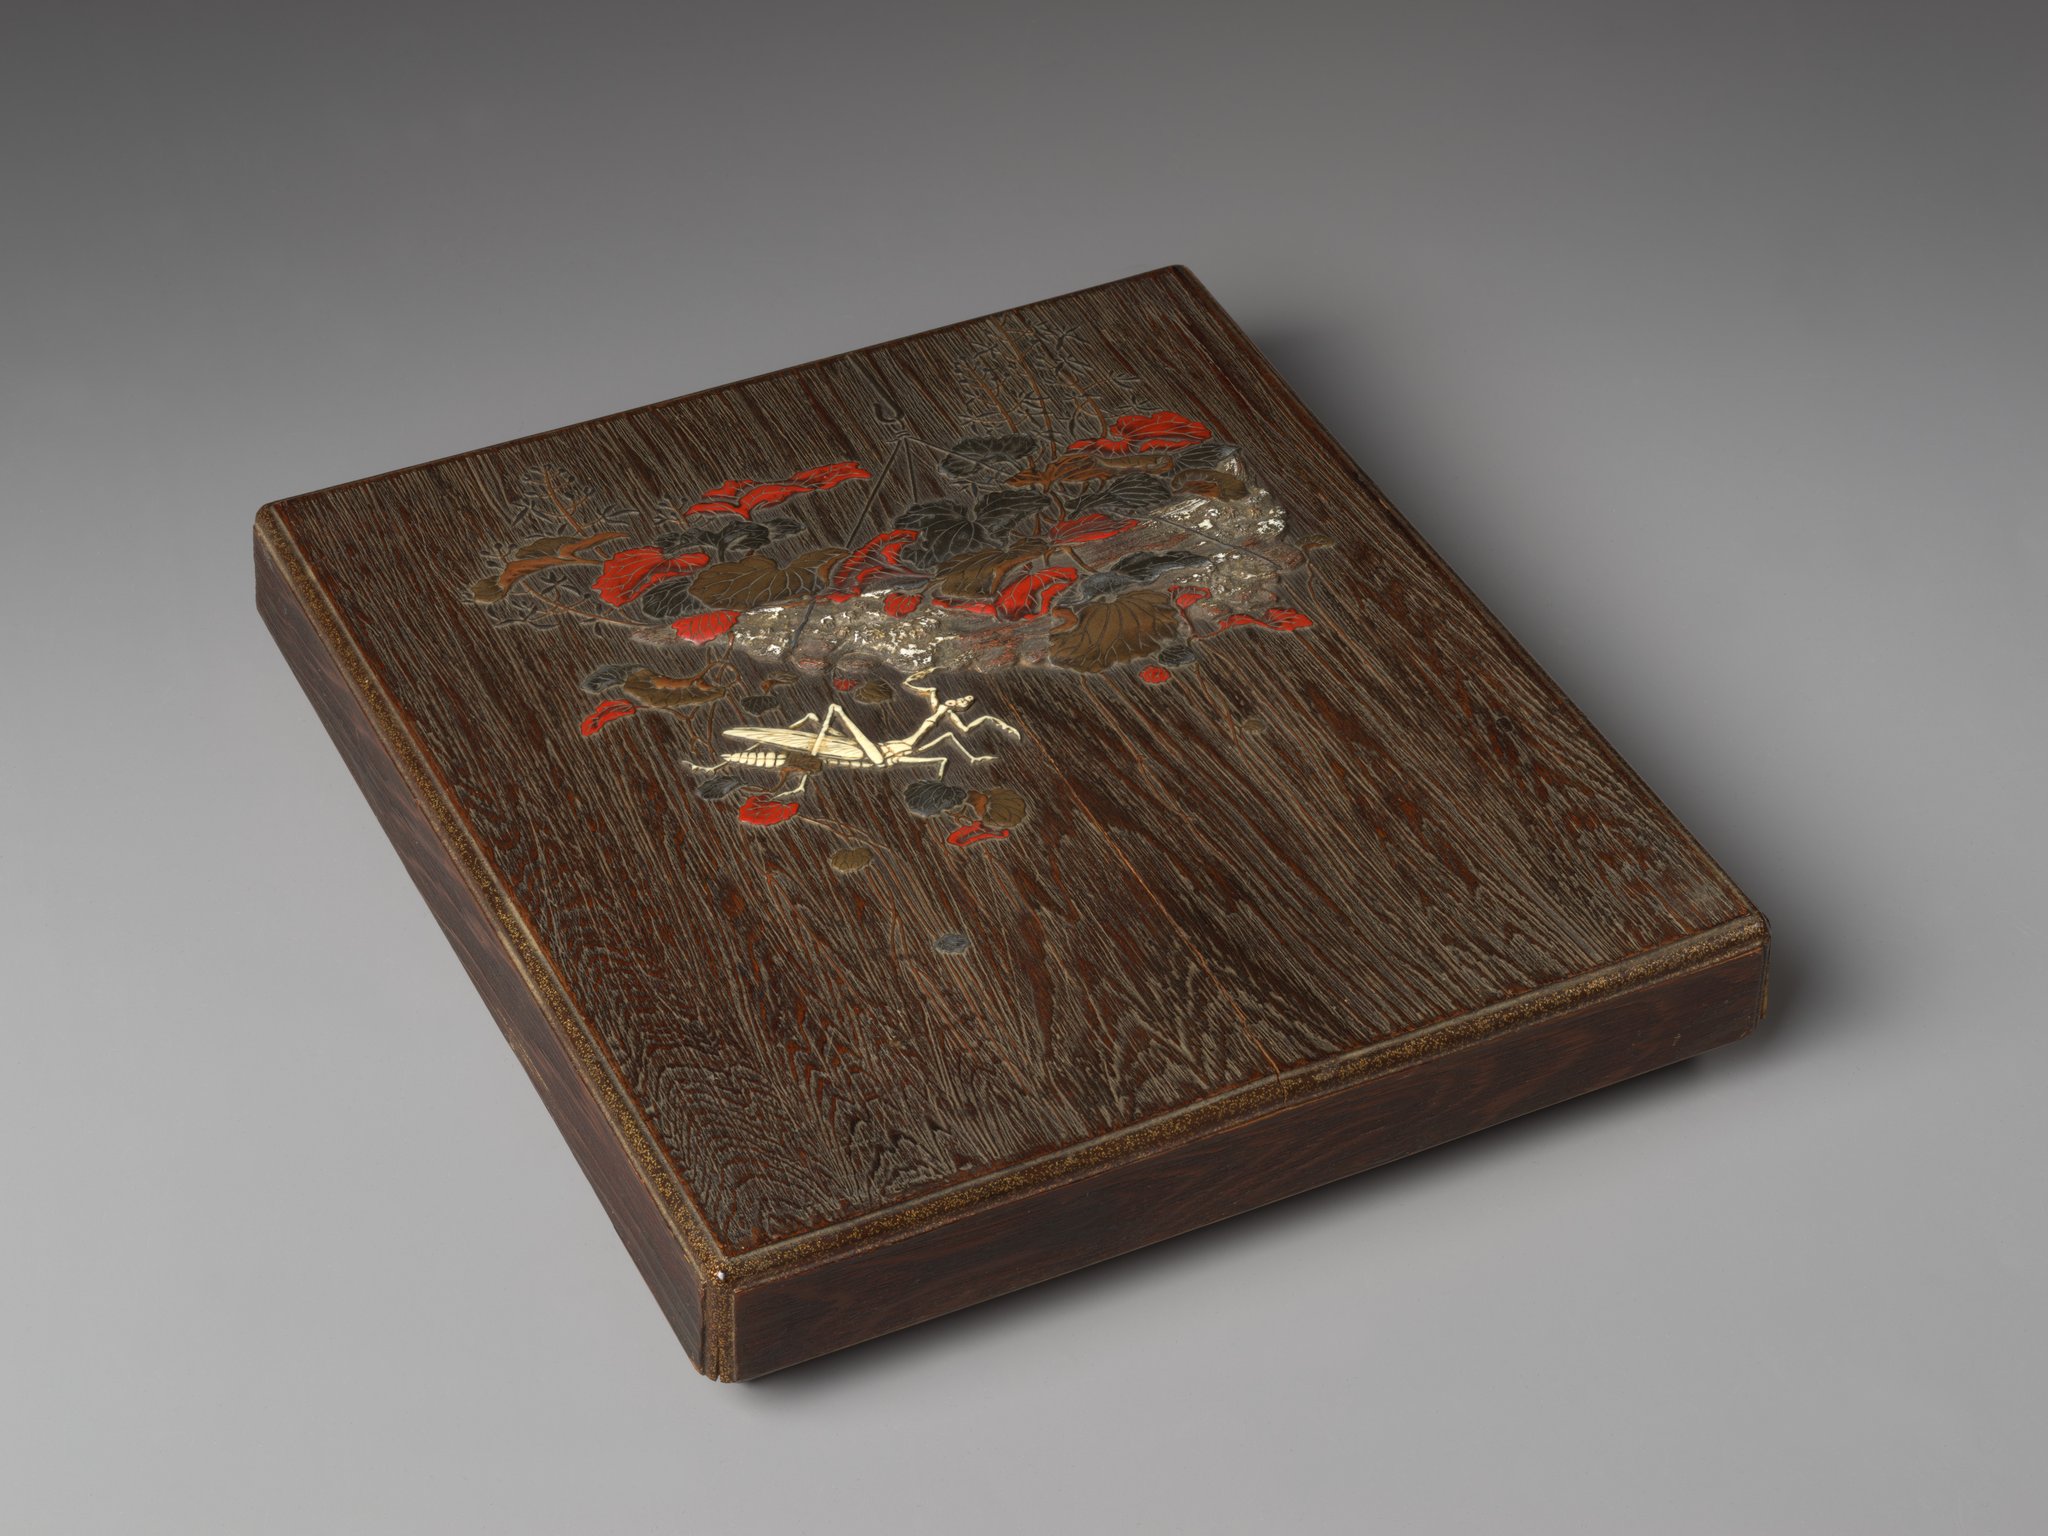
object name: box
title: Writing box with design of praying mantis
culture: japanese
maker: ogawa haritsu (ritsuō)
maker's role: artist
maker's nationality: japanese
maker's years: 1663-1747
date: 1615-1868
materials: bone, enamel, lacquer, pottery, wood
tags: insects